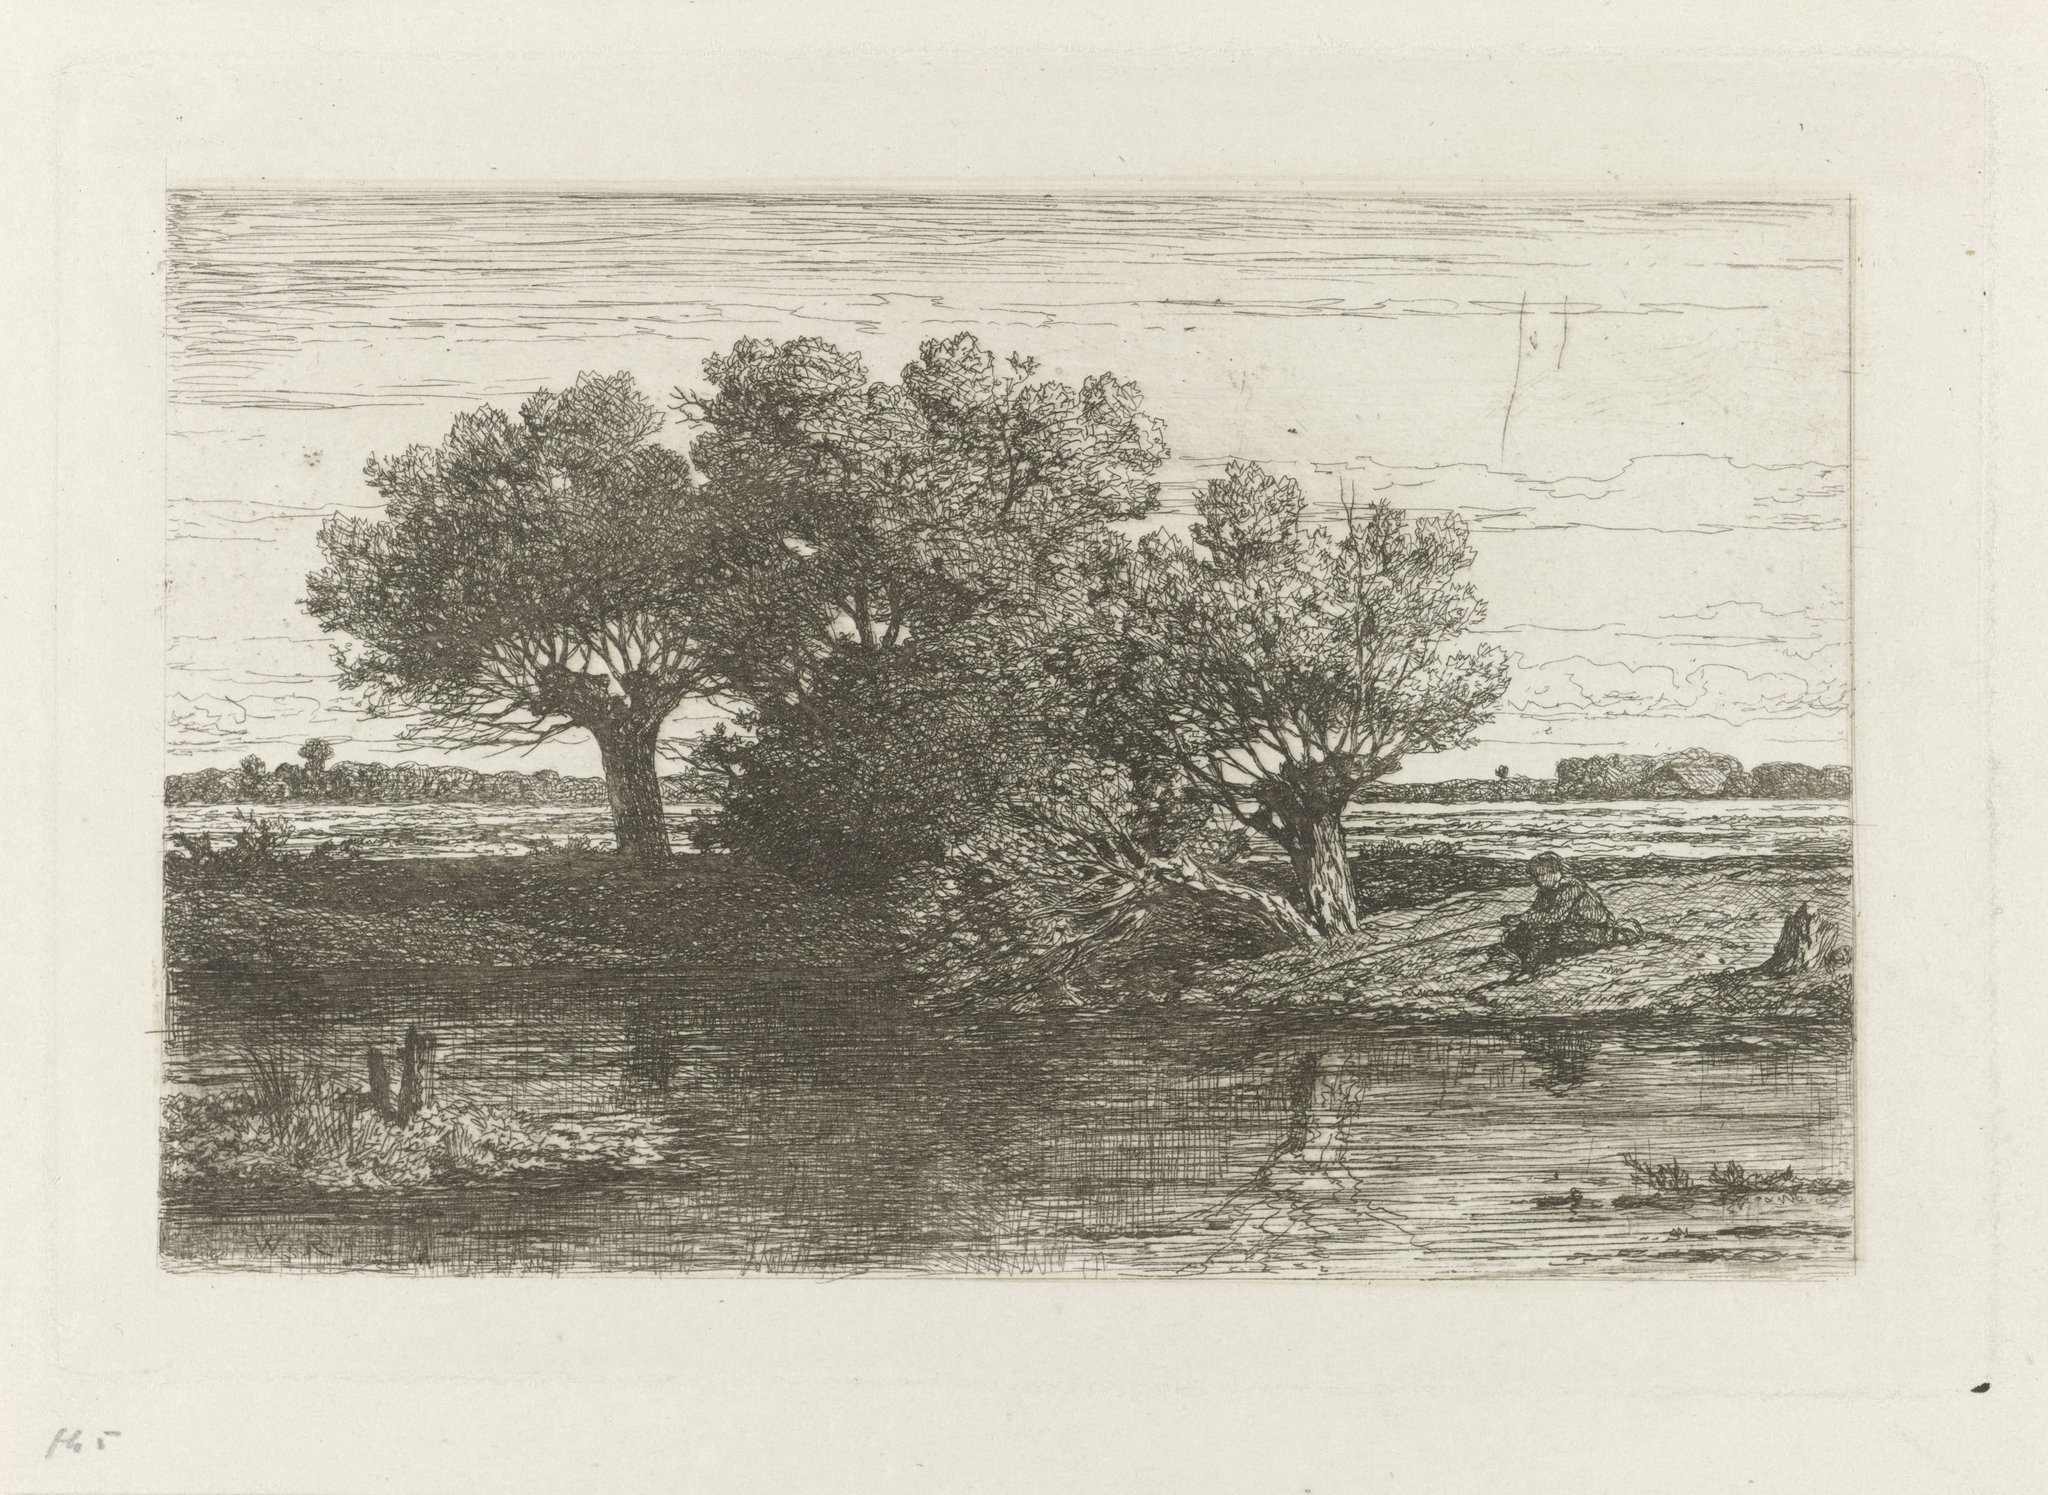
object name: print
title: Visser bij knotwilgen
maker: willem roelofs (i)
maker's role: draughtsman, painter, print maker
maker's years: 1822-1897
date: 1832-1893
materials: paper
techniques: drypoint, etching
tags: river, trees: willow, farm or solitary house in landscape, fisherman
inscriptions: inscription: ‘Le pêcheur près des saules / 1e staat voor de [...]’, collector's mark: Lugt 2228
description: Aan de rand van een riviertje zit een man te vissen. Naast hem enkele knotwilgen. Op de achtergrond de bosrand en een boerderij.